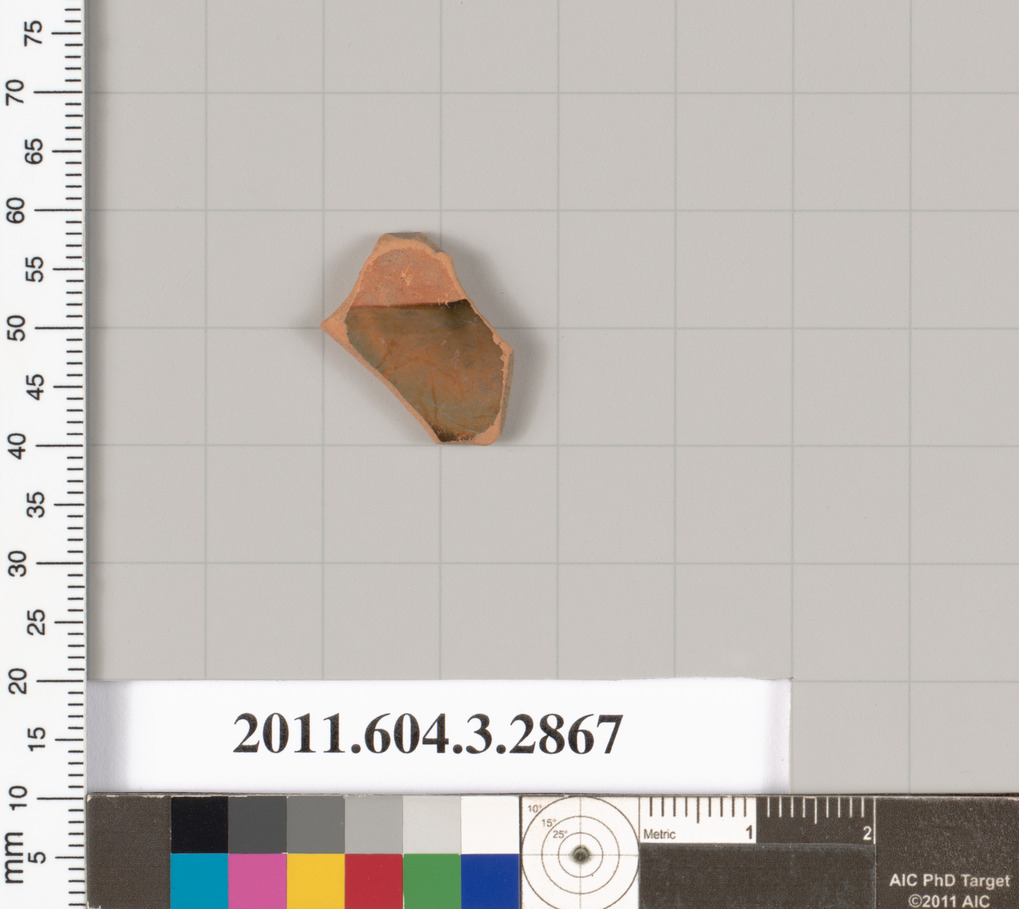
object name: undetermined shape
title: Terracotta fragment of an undetermined shape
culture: greek, attic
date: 600-401 BCE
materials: terracotta